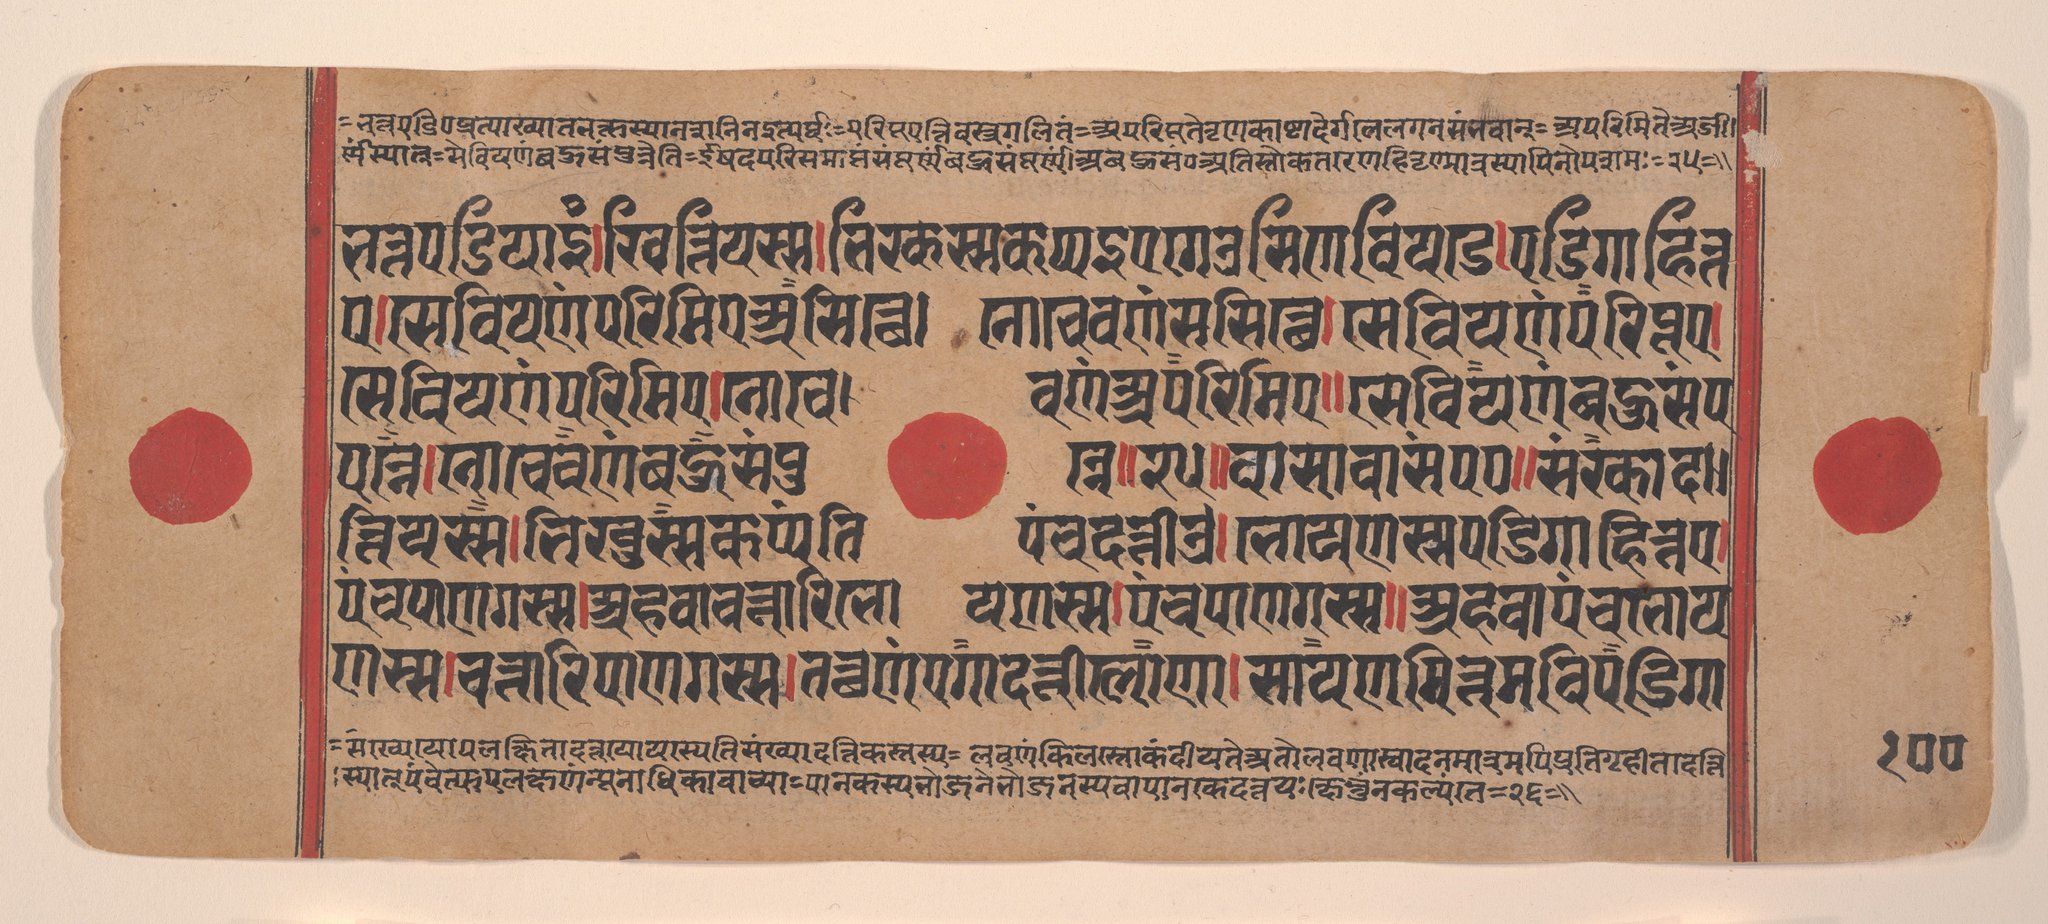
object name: folio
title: Page from a Dispersed Kalpa Sutra (Jain Book of Rituals)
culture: indian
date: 1401-1500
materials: gold, ink, paper, watercolor